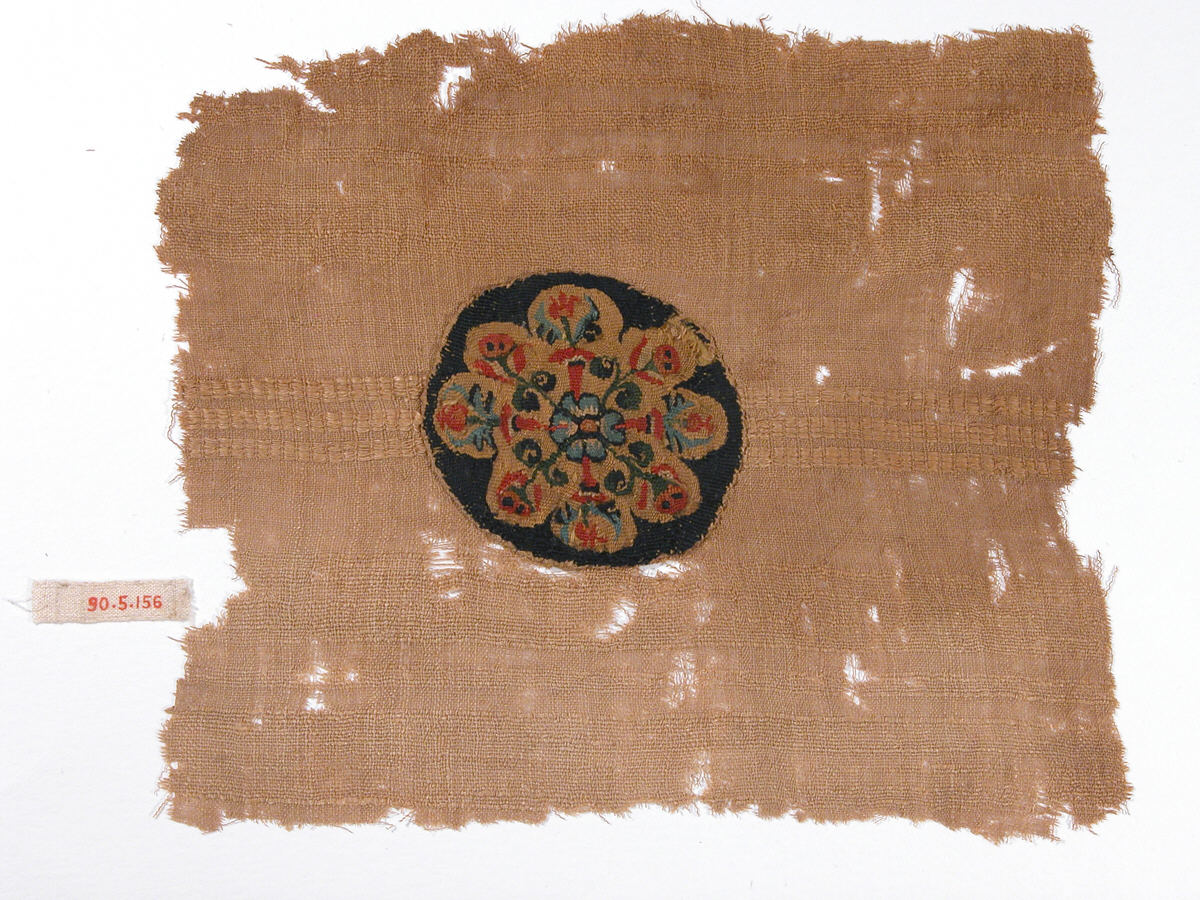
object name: textile fragment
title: Fragment with a Composite Floral Motif Roundel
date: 401-600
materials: linen, wool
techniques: weave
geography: egypt